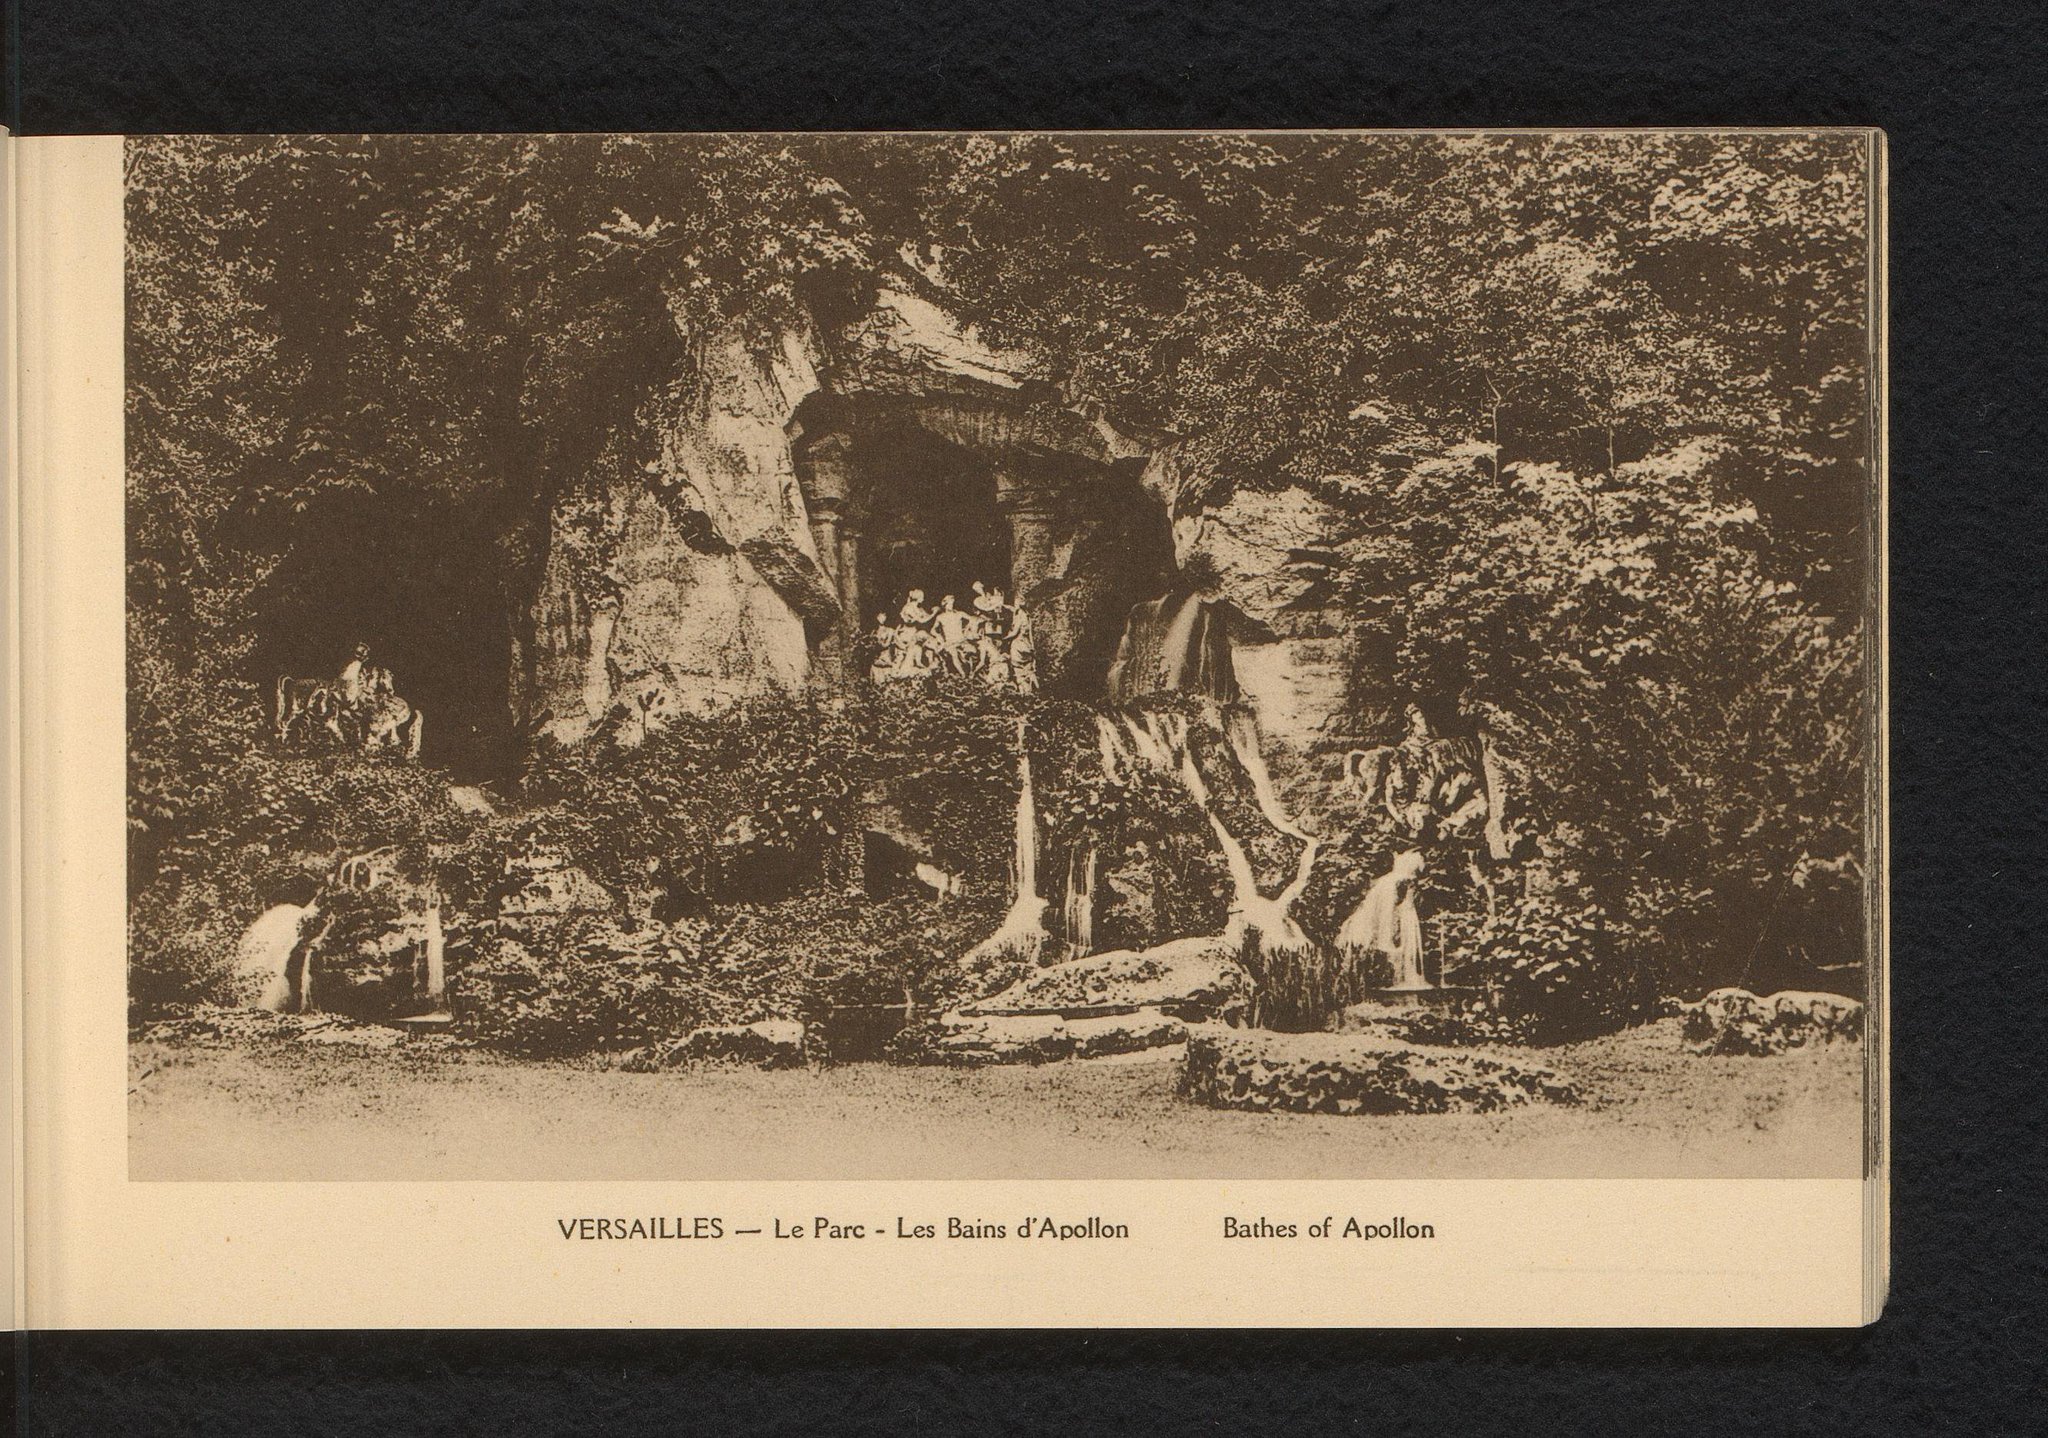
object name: photomechanical print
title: Versailles. Le Parc. Les Bains d'Apollon / Bathes of Apollon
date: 1919-1930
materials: cardboard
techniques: photograph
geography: paris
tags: french or architectonic garden; formal garden, water-works in garden, statues, sculptures in garden